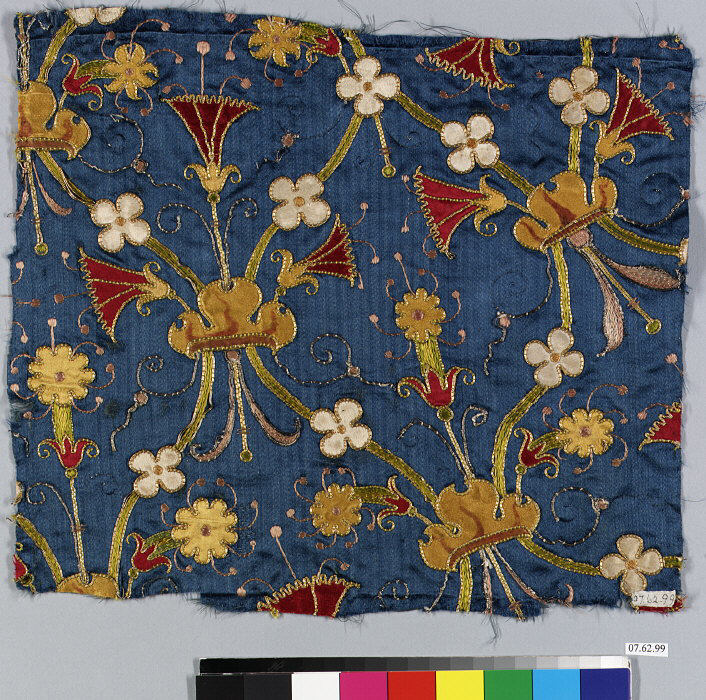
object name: piece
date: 1601-1800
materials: metal thread, silk